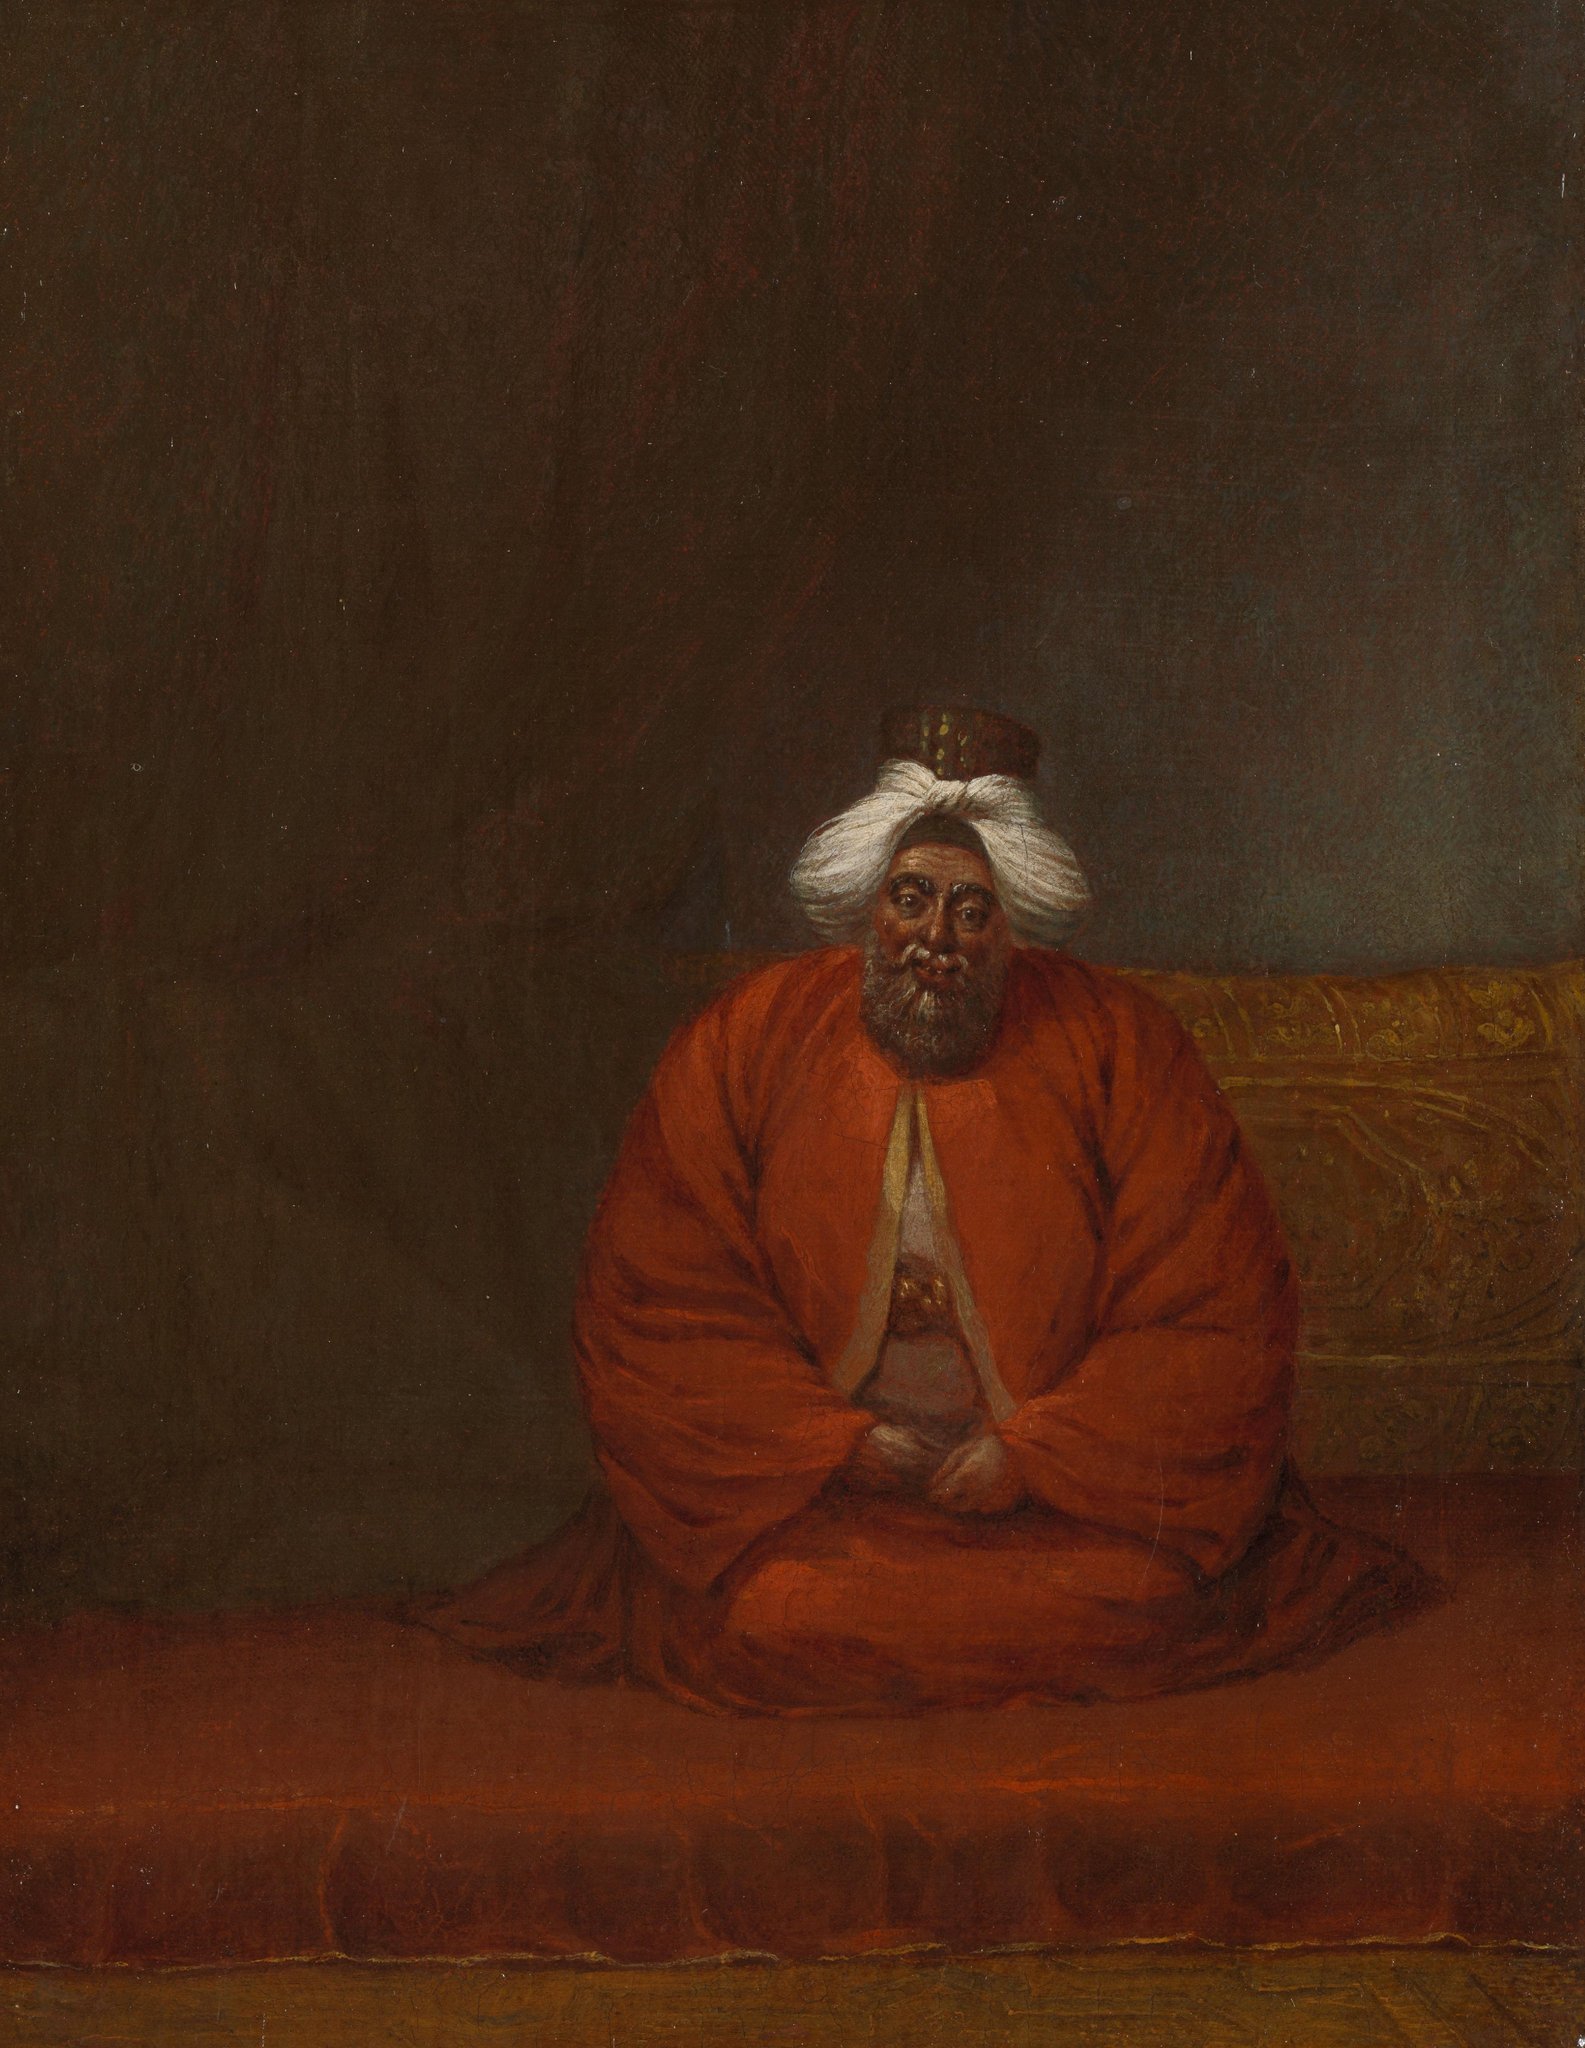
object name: painting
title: The Mufti, Supreme Religious Leader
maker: jean baptiste vanmour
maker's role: painter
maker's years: 1671-1737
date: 1727-1730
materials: canvas, oil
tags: head-gear: turban, religious functionaries ~ islam, mohammedanism, historical persons not known by name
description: A mufti is an Islamic ecclesiastical legal authority. The mufti of Istanbul, called the şeyhülislam, was the highest-ranking religious functionary in the Ottoman Empire. He, the grand vizier and the sultan were the three most important rulers. The şeyhülislam had to ensure that the policy of the sultan and his grand vizier did not violate the sharia or holy law of Islam.